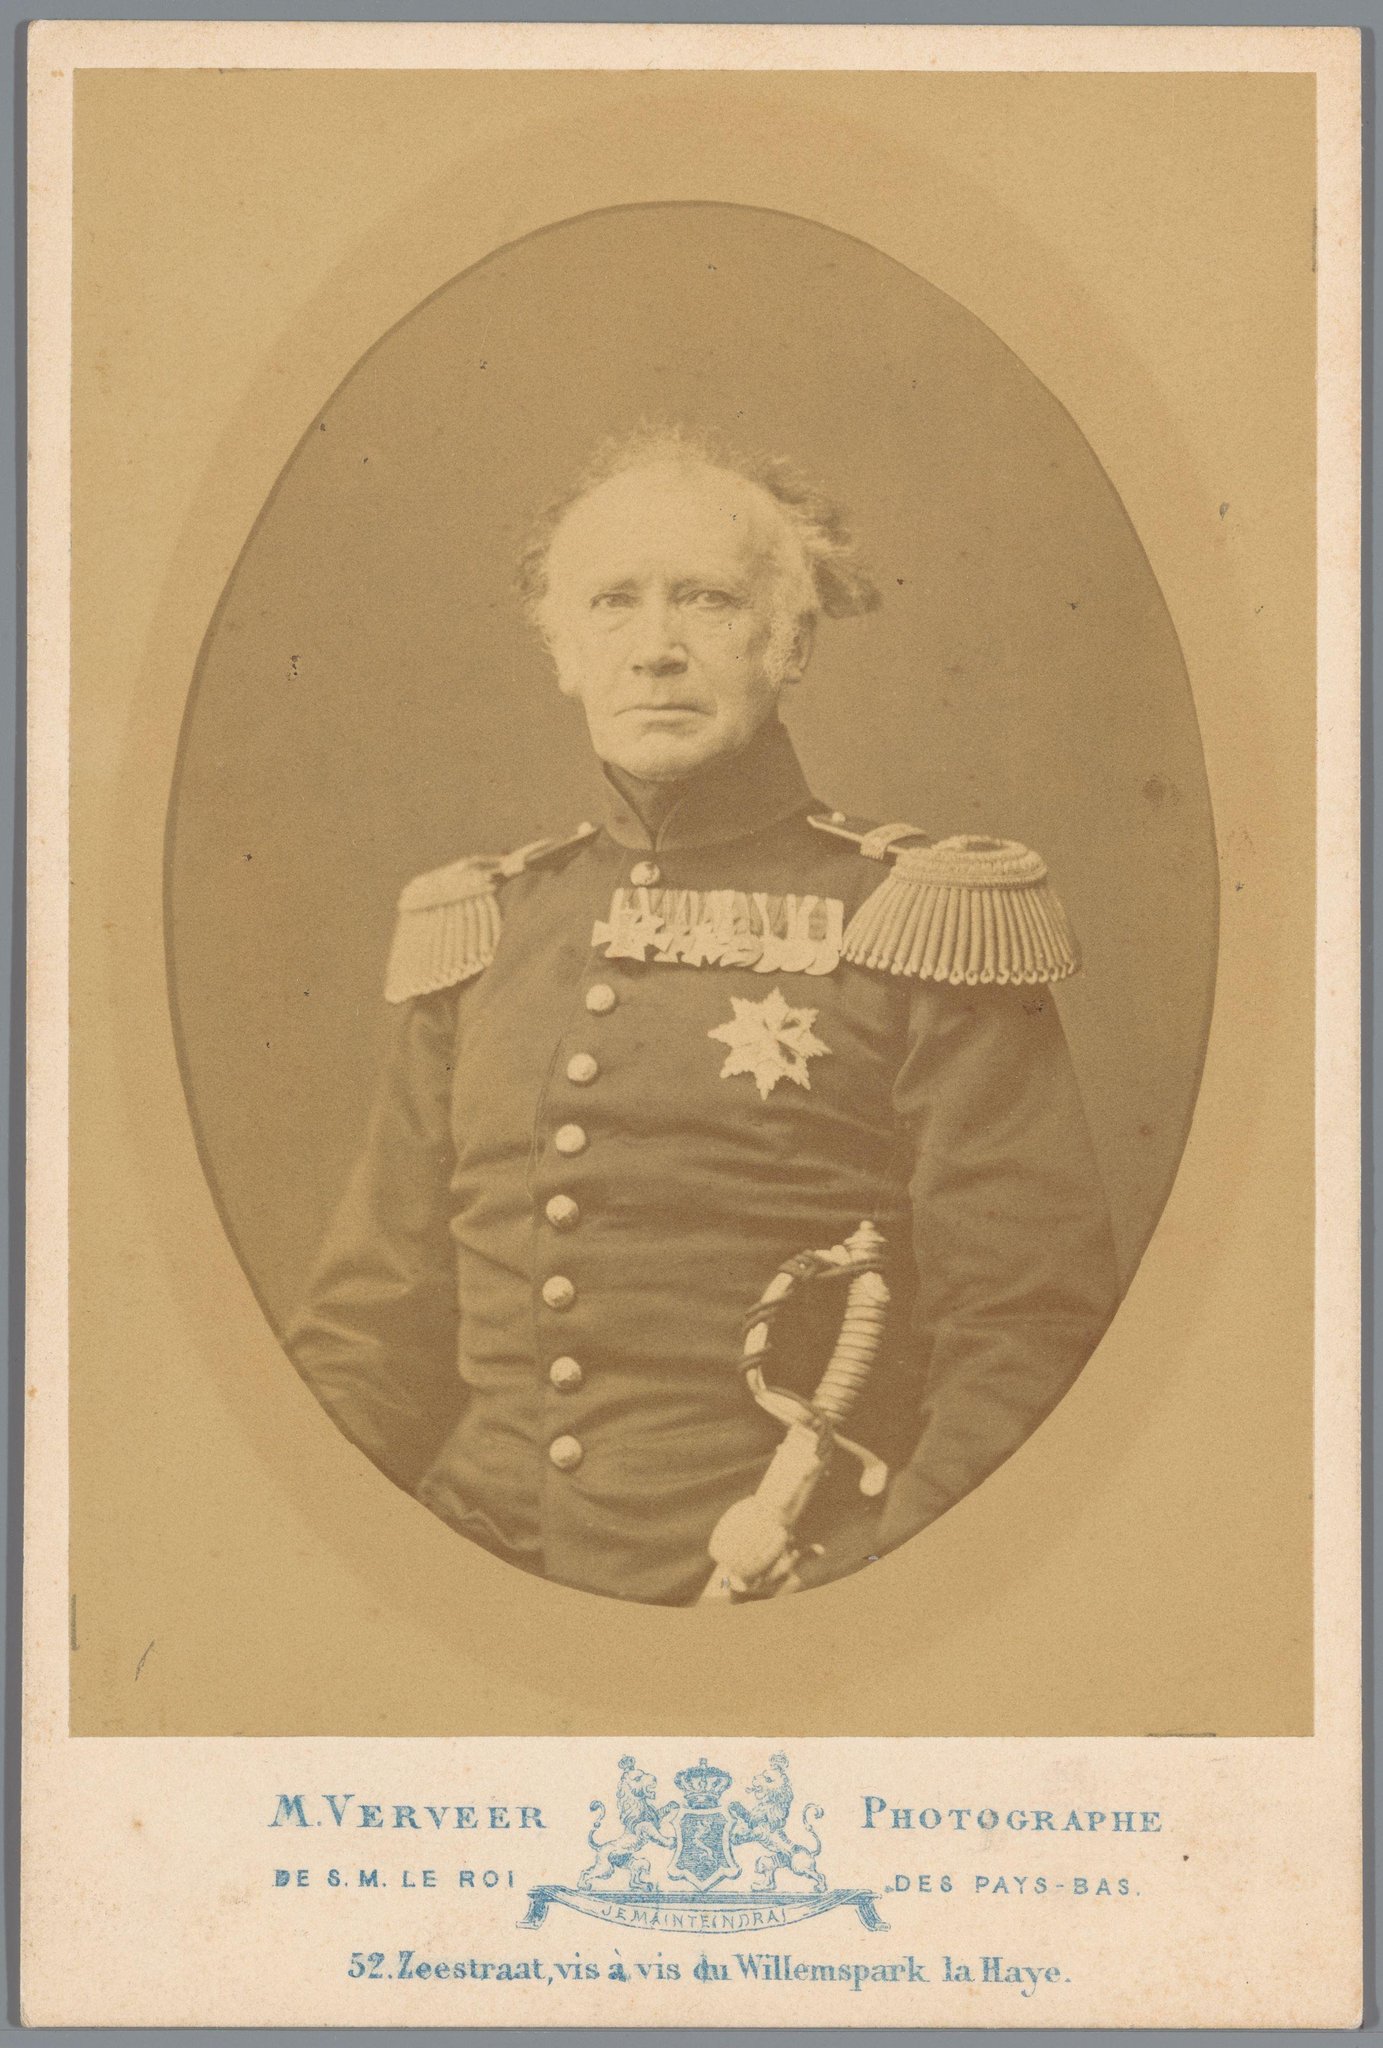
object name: cabinet photograph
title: Portret van prins Frederik in uniform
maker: maurits verveer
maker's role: painter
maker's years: 1817-1903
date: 1875-1881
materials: cardboard, paper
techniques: albumen print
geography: breda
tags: berlin, frederik (prins der nederlanden), historical persons, (military) uniforms, the hague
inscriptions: label: ‘ALGEMEENE BOEKHANDEL/ Boekdrukk[...]/ BROESE & COMP./ Courantiers/ BREDA, GROOTE MARKT’, inscription: ‘M. VERVEER/ PHOTOGRAPHE/ DE S.M. LE ROI/ DES PAYS-BAS./ 52, Zeestraat, vis à vis du Willemspark la Haye.’